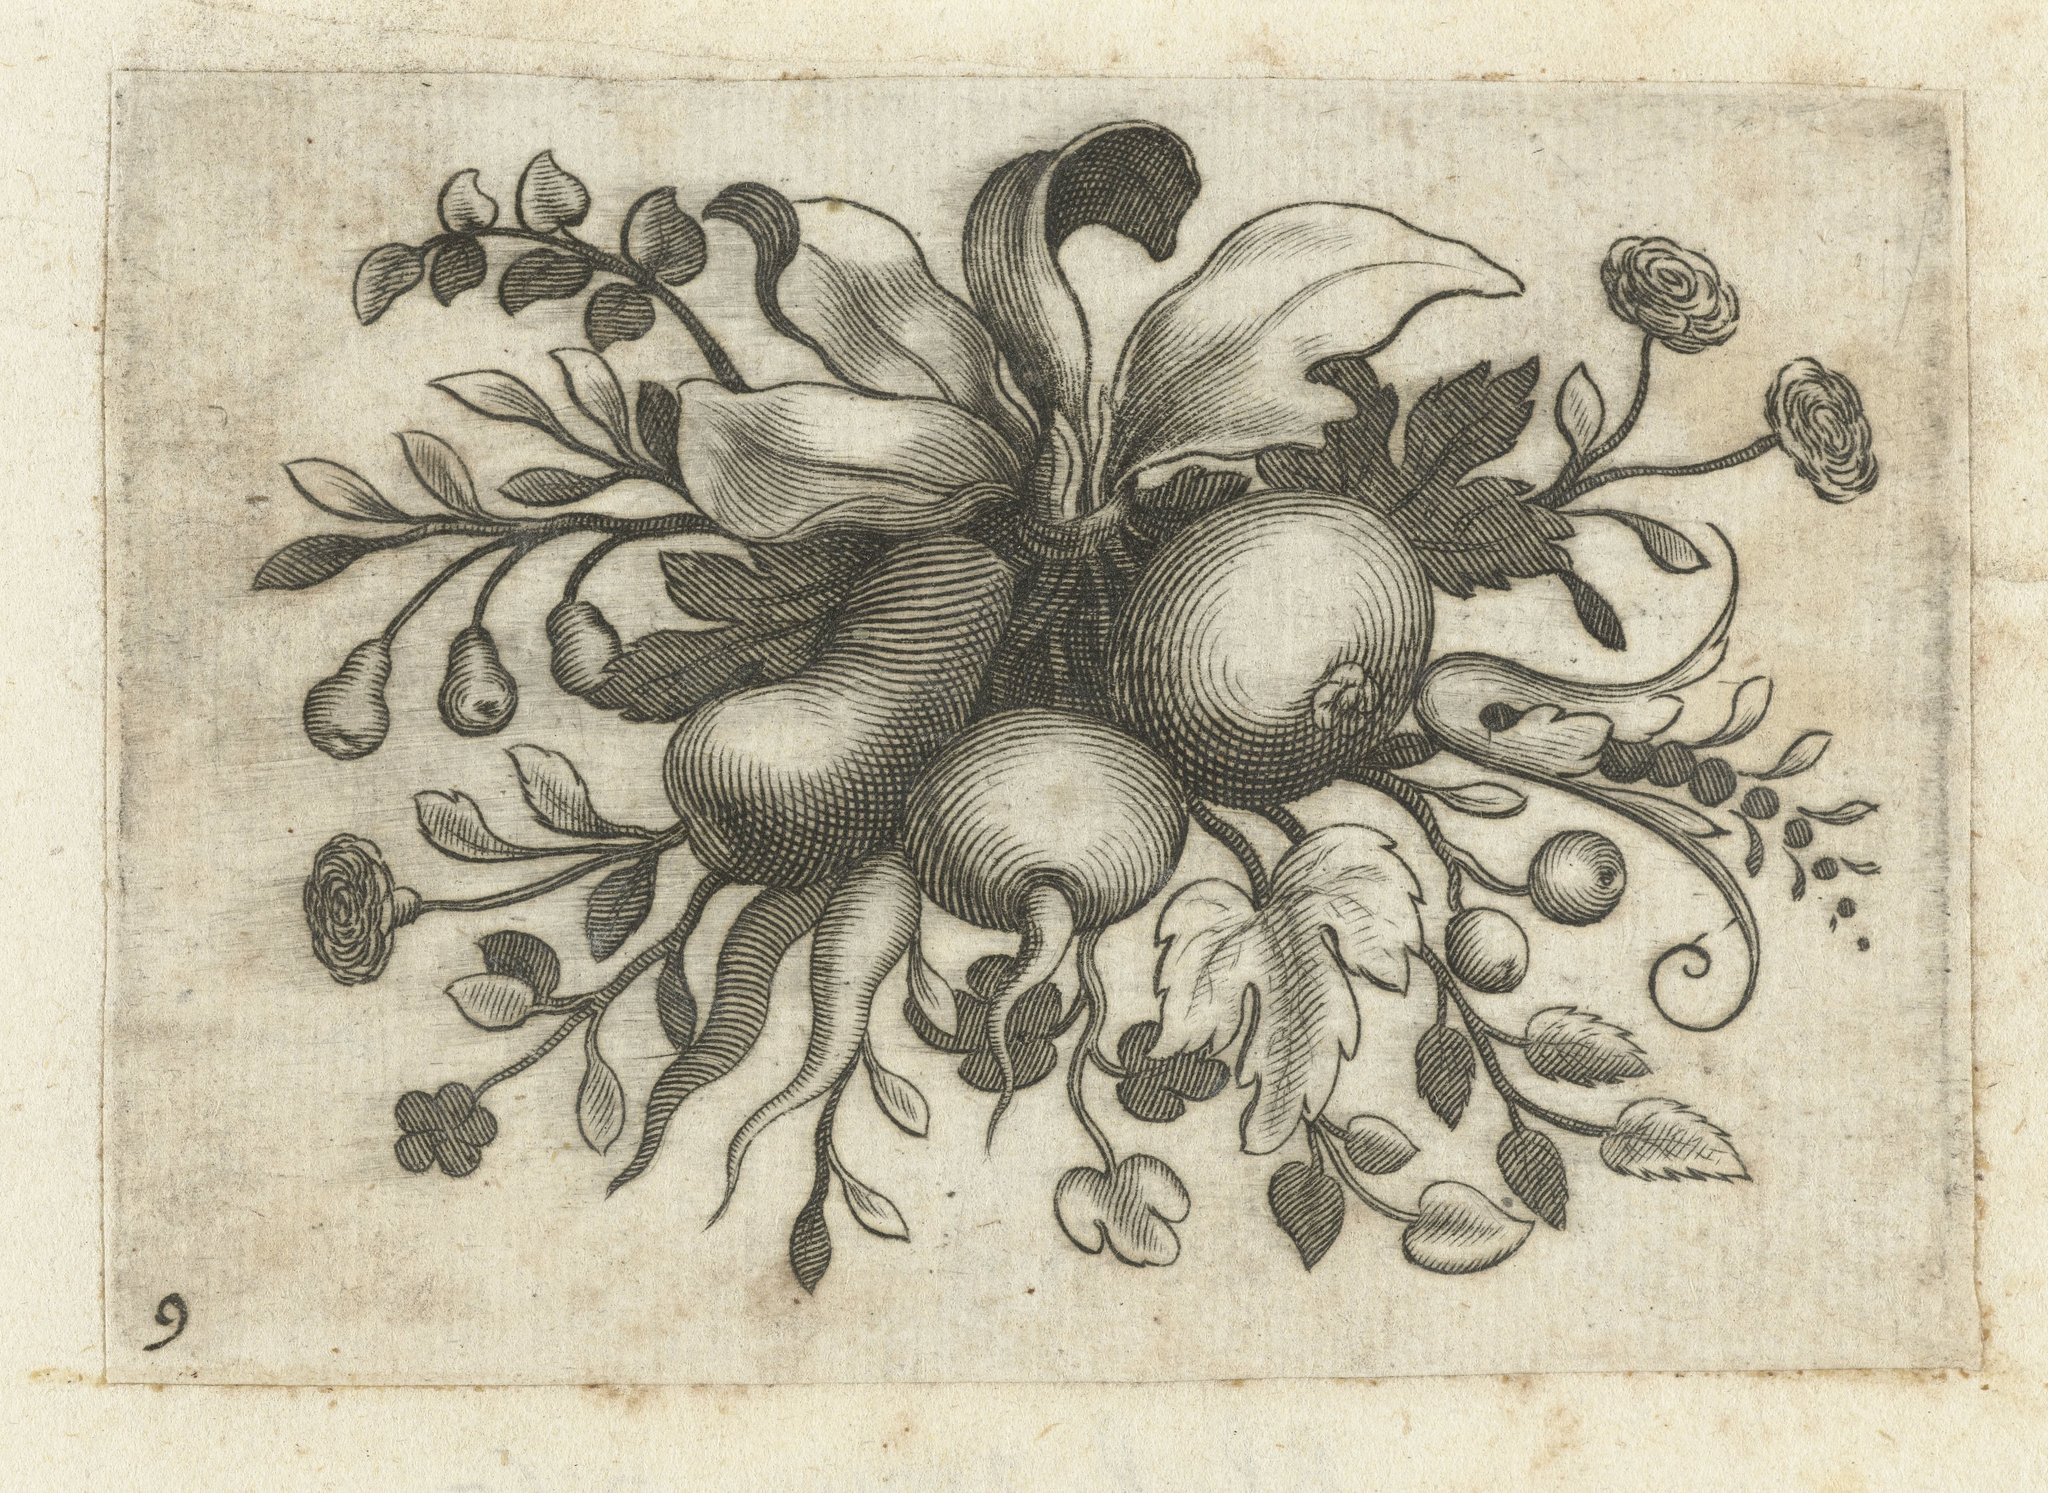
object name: print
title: Fruchtenbuchlein zum Reisen dienlich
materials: paper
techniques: engraving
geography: germany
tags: fruits and vegetables ~ ornament, ornament ~ festoon, garland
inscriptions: number: ‘9’